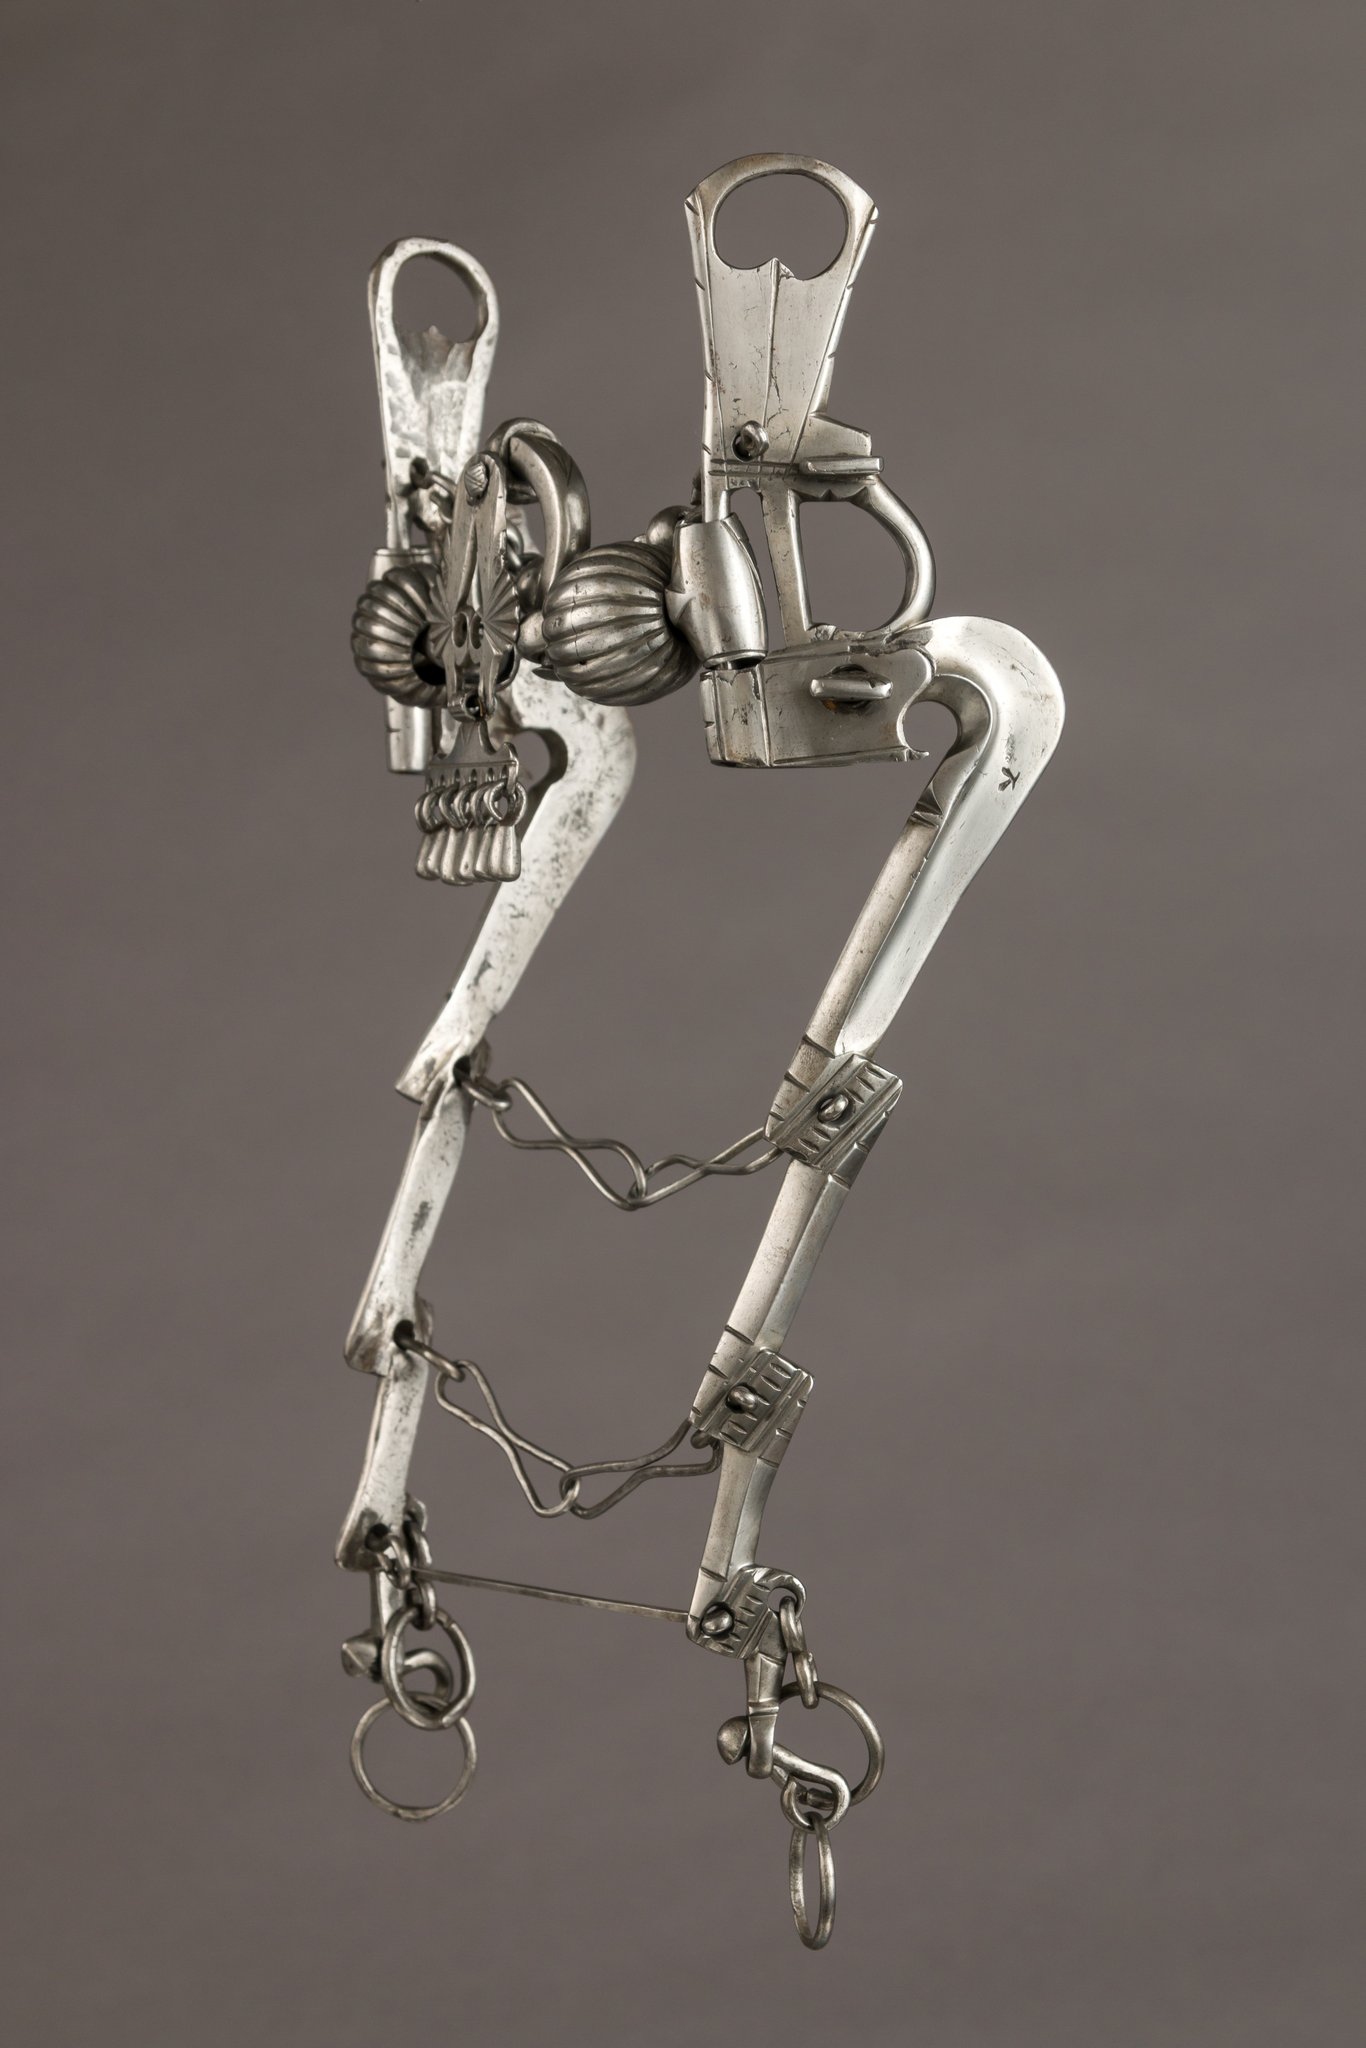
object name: bit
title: Curb Bit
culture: german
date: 1551-1600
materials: metal alloy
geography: germany